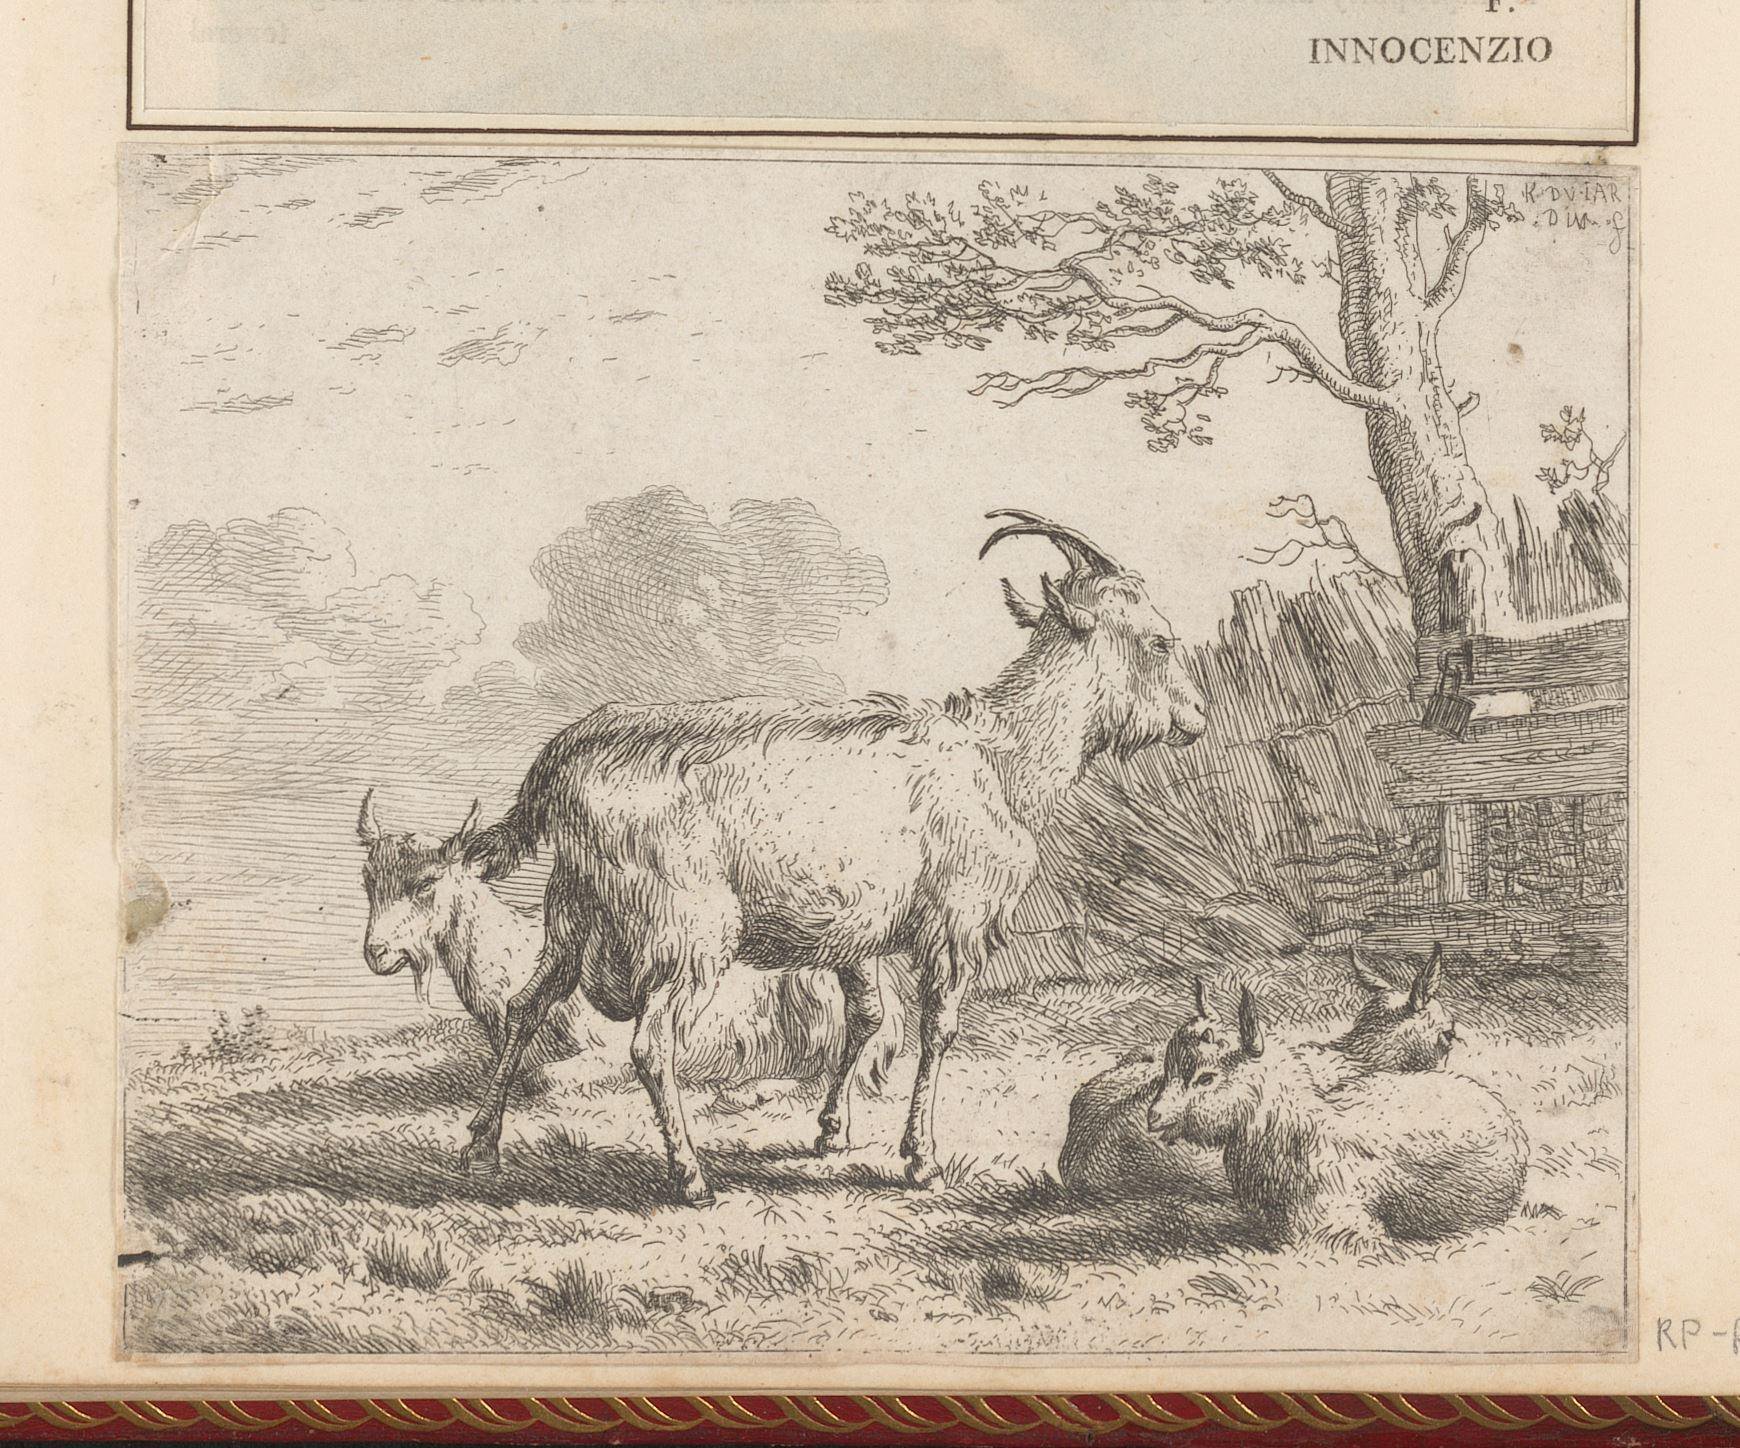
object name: album leaf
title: Geiten met twee lammeren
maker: karel du jardin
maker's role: draughtsman, painter, print maker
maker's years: 1626-1678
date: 1636-1678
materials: paper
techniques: etching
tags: goat, kid (goat)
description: De samensteller heeft deze prent in het album geplakt als illustratie bij: Pilkington, Matthew en Johann Heinrich Füssli. A dictionary of painters, from the revival of the art to the present period. 4 dln. Londen: John Crowder, 1805, dl. 2, p. 262.